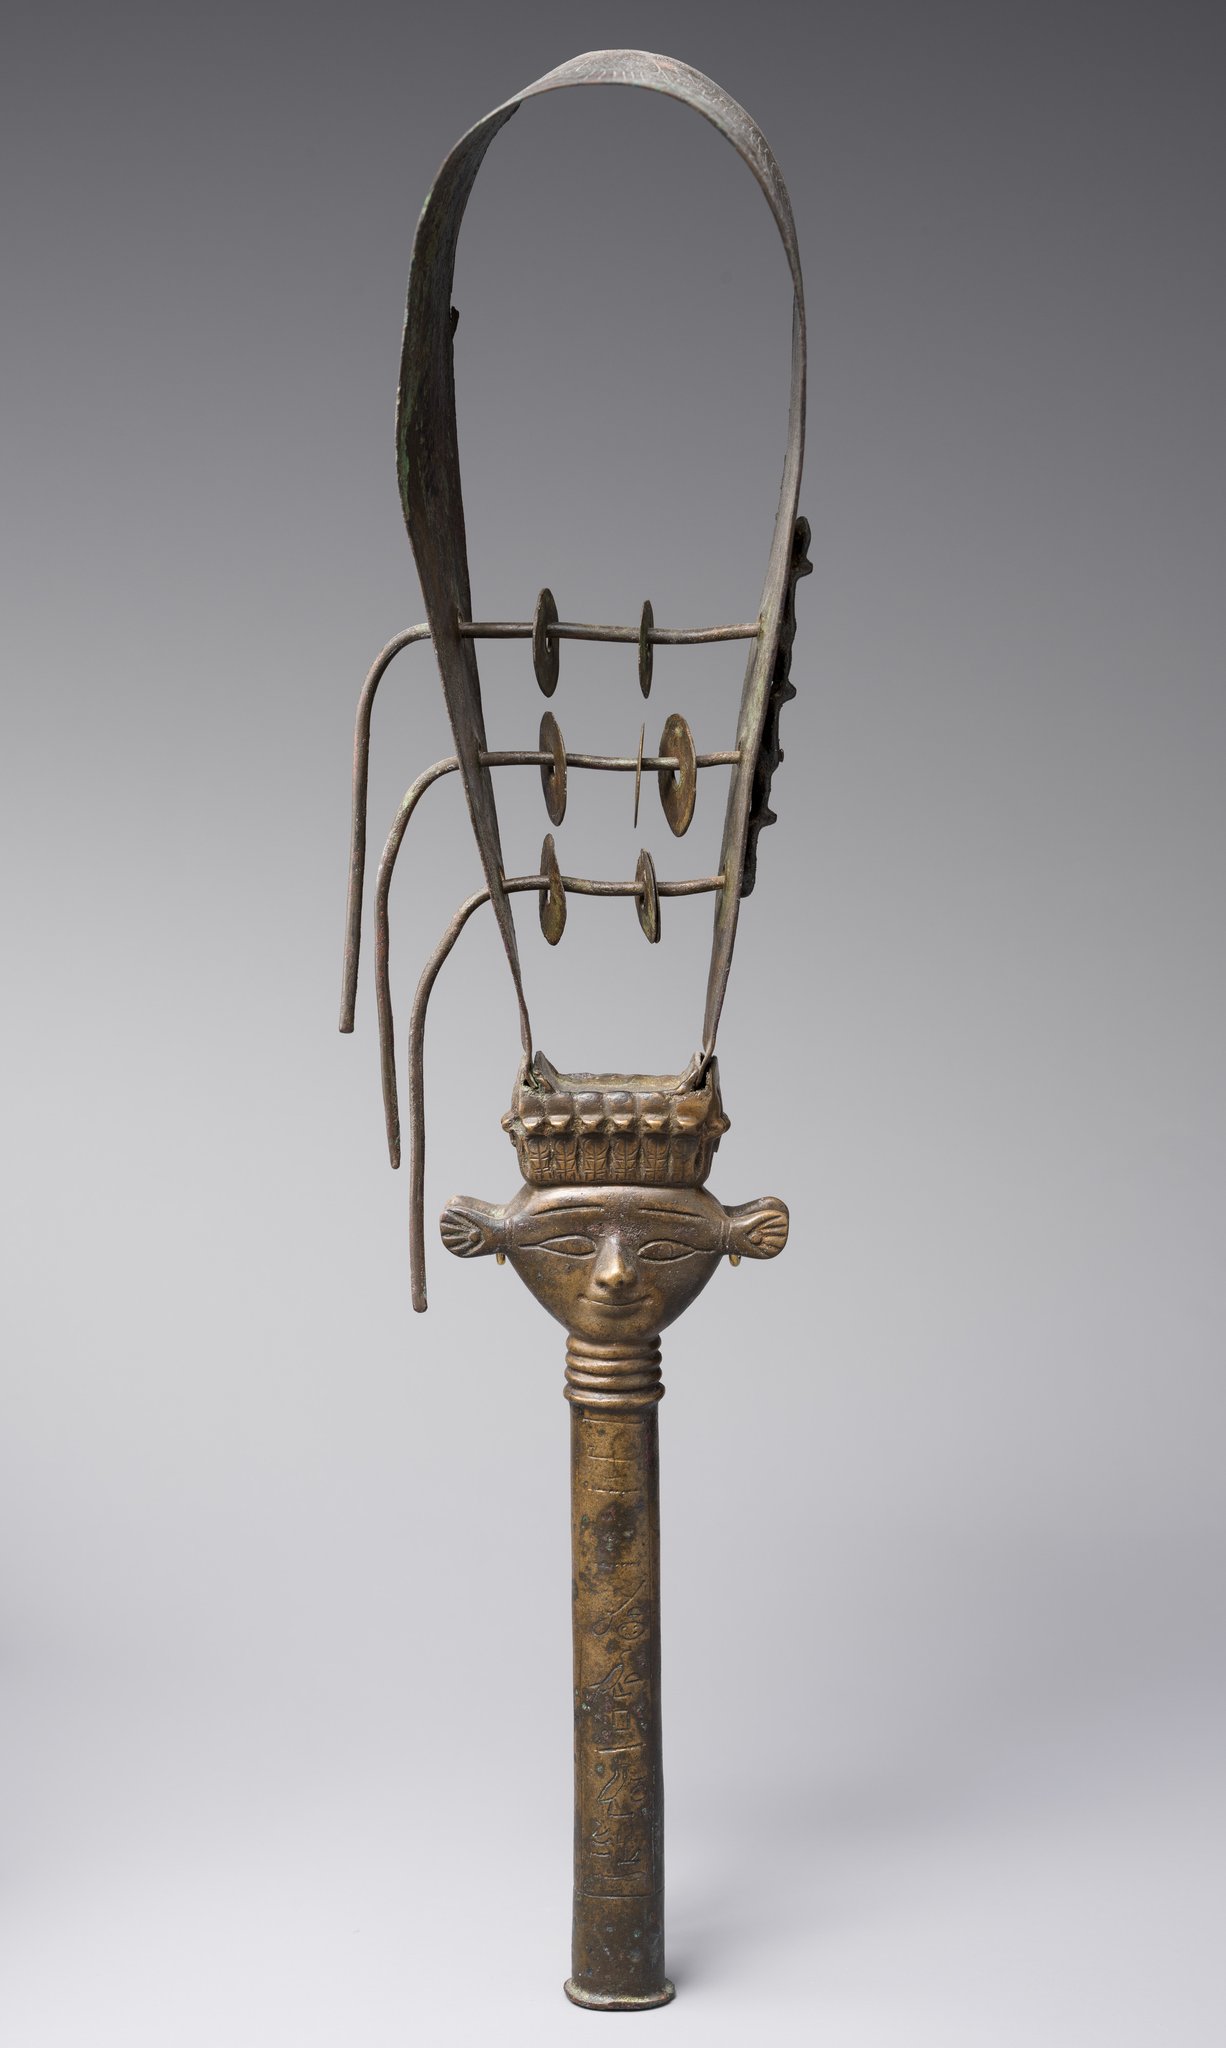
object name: music, sistrum, hathor emblem, bat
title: Arc sistrum of Tapenu, chantress of Sobek of Khenyt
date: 1186-600 BCE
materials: metal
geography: southern upper egypt